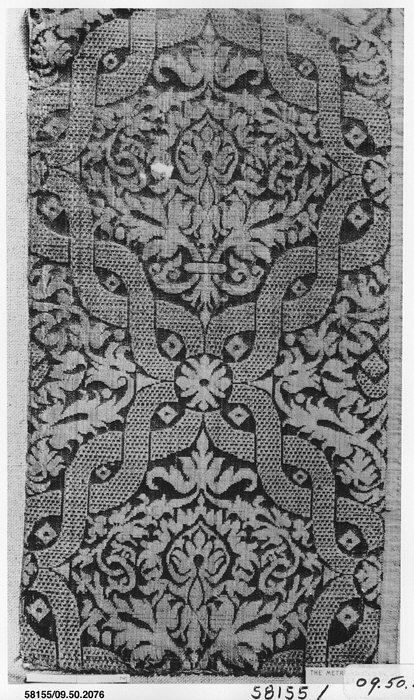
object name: piece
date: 1501-1600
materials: silk